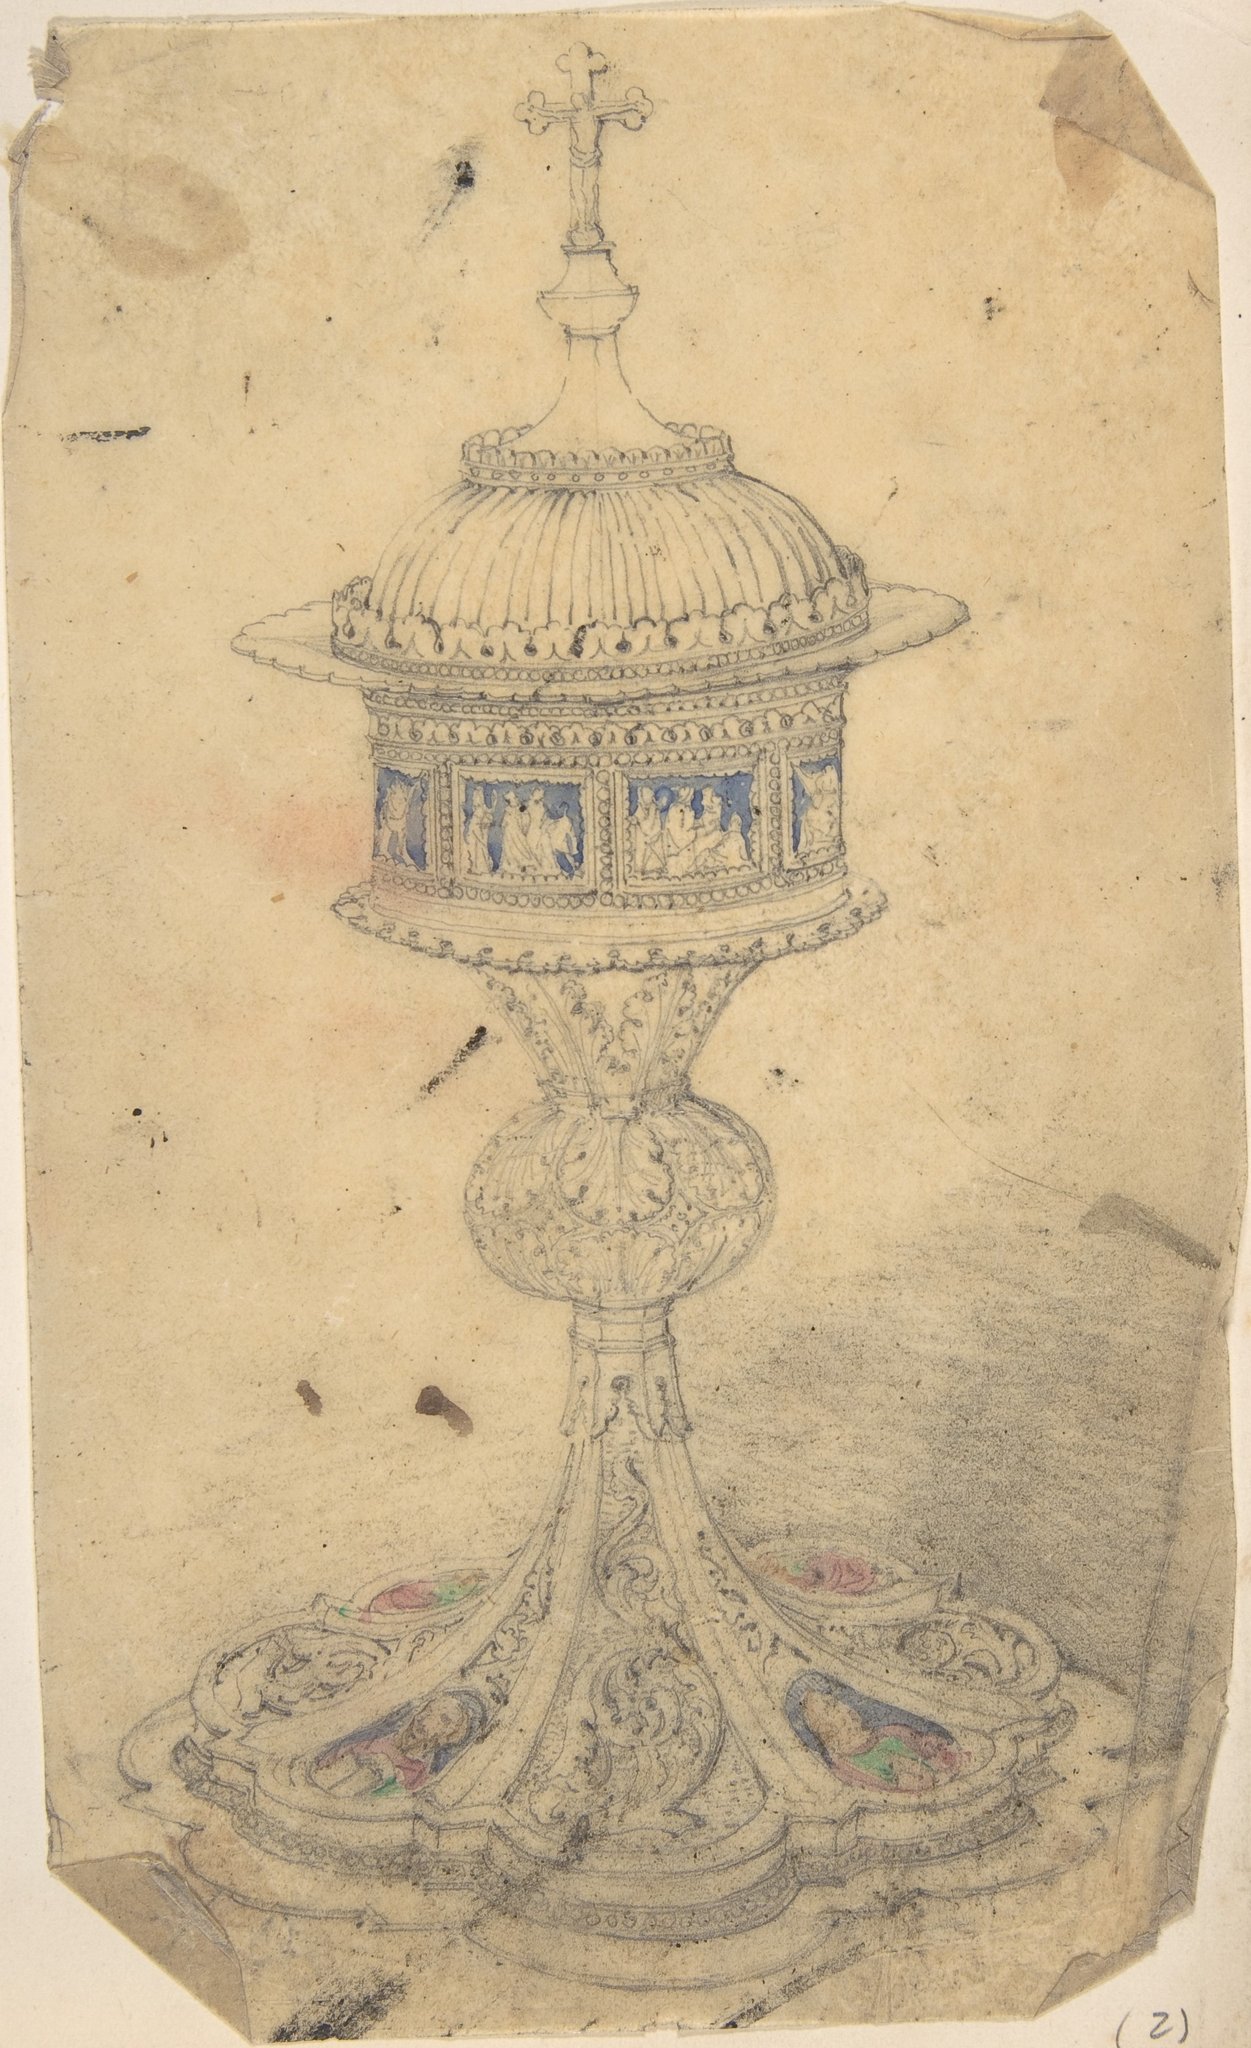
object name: drawing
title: Liturgical Incense Burner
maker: anonymous, british, 19th century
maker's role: artist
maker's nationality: british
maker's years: 1800-1900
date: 1851-1900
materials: graphite, watercolor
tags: incense burners